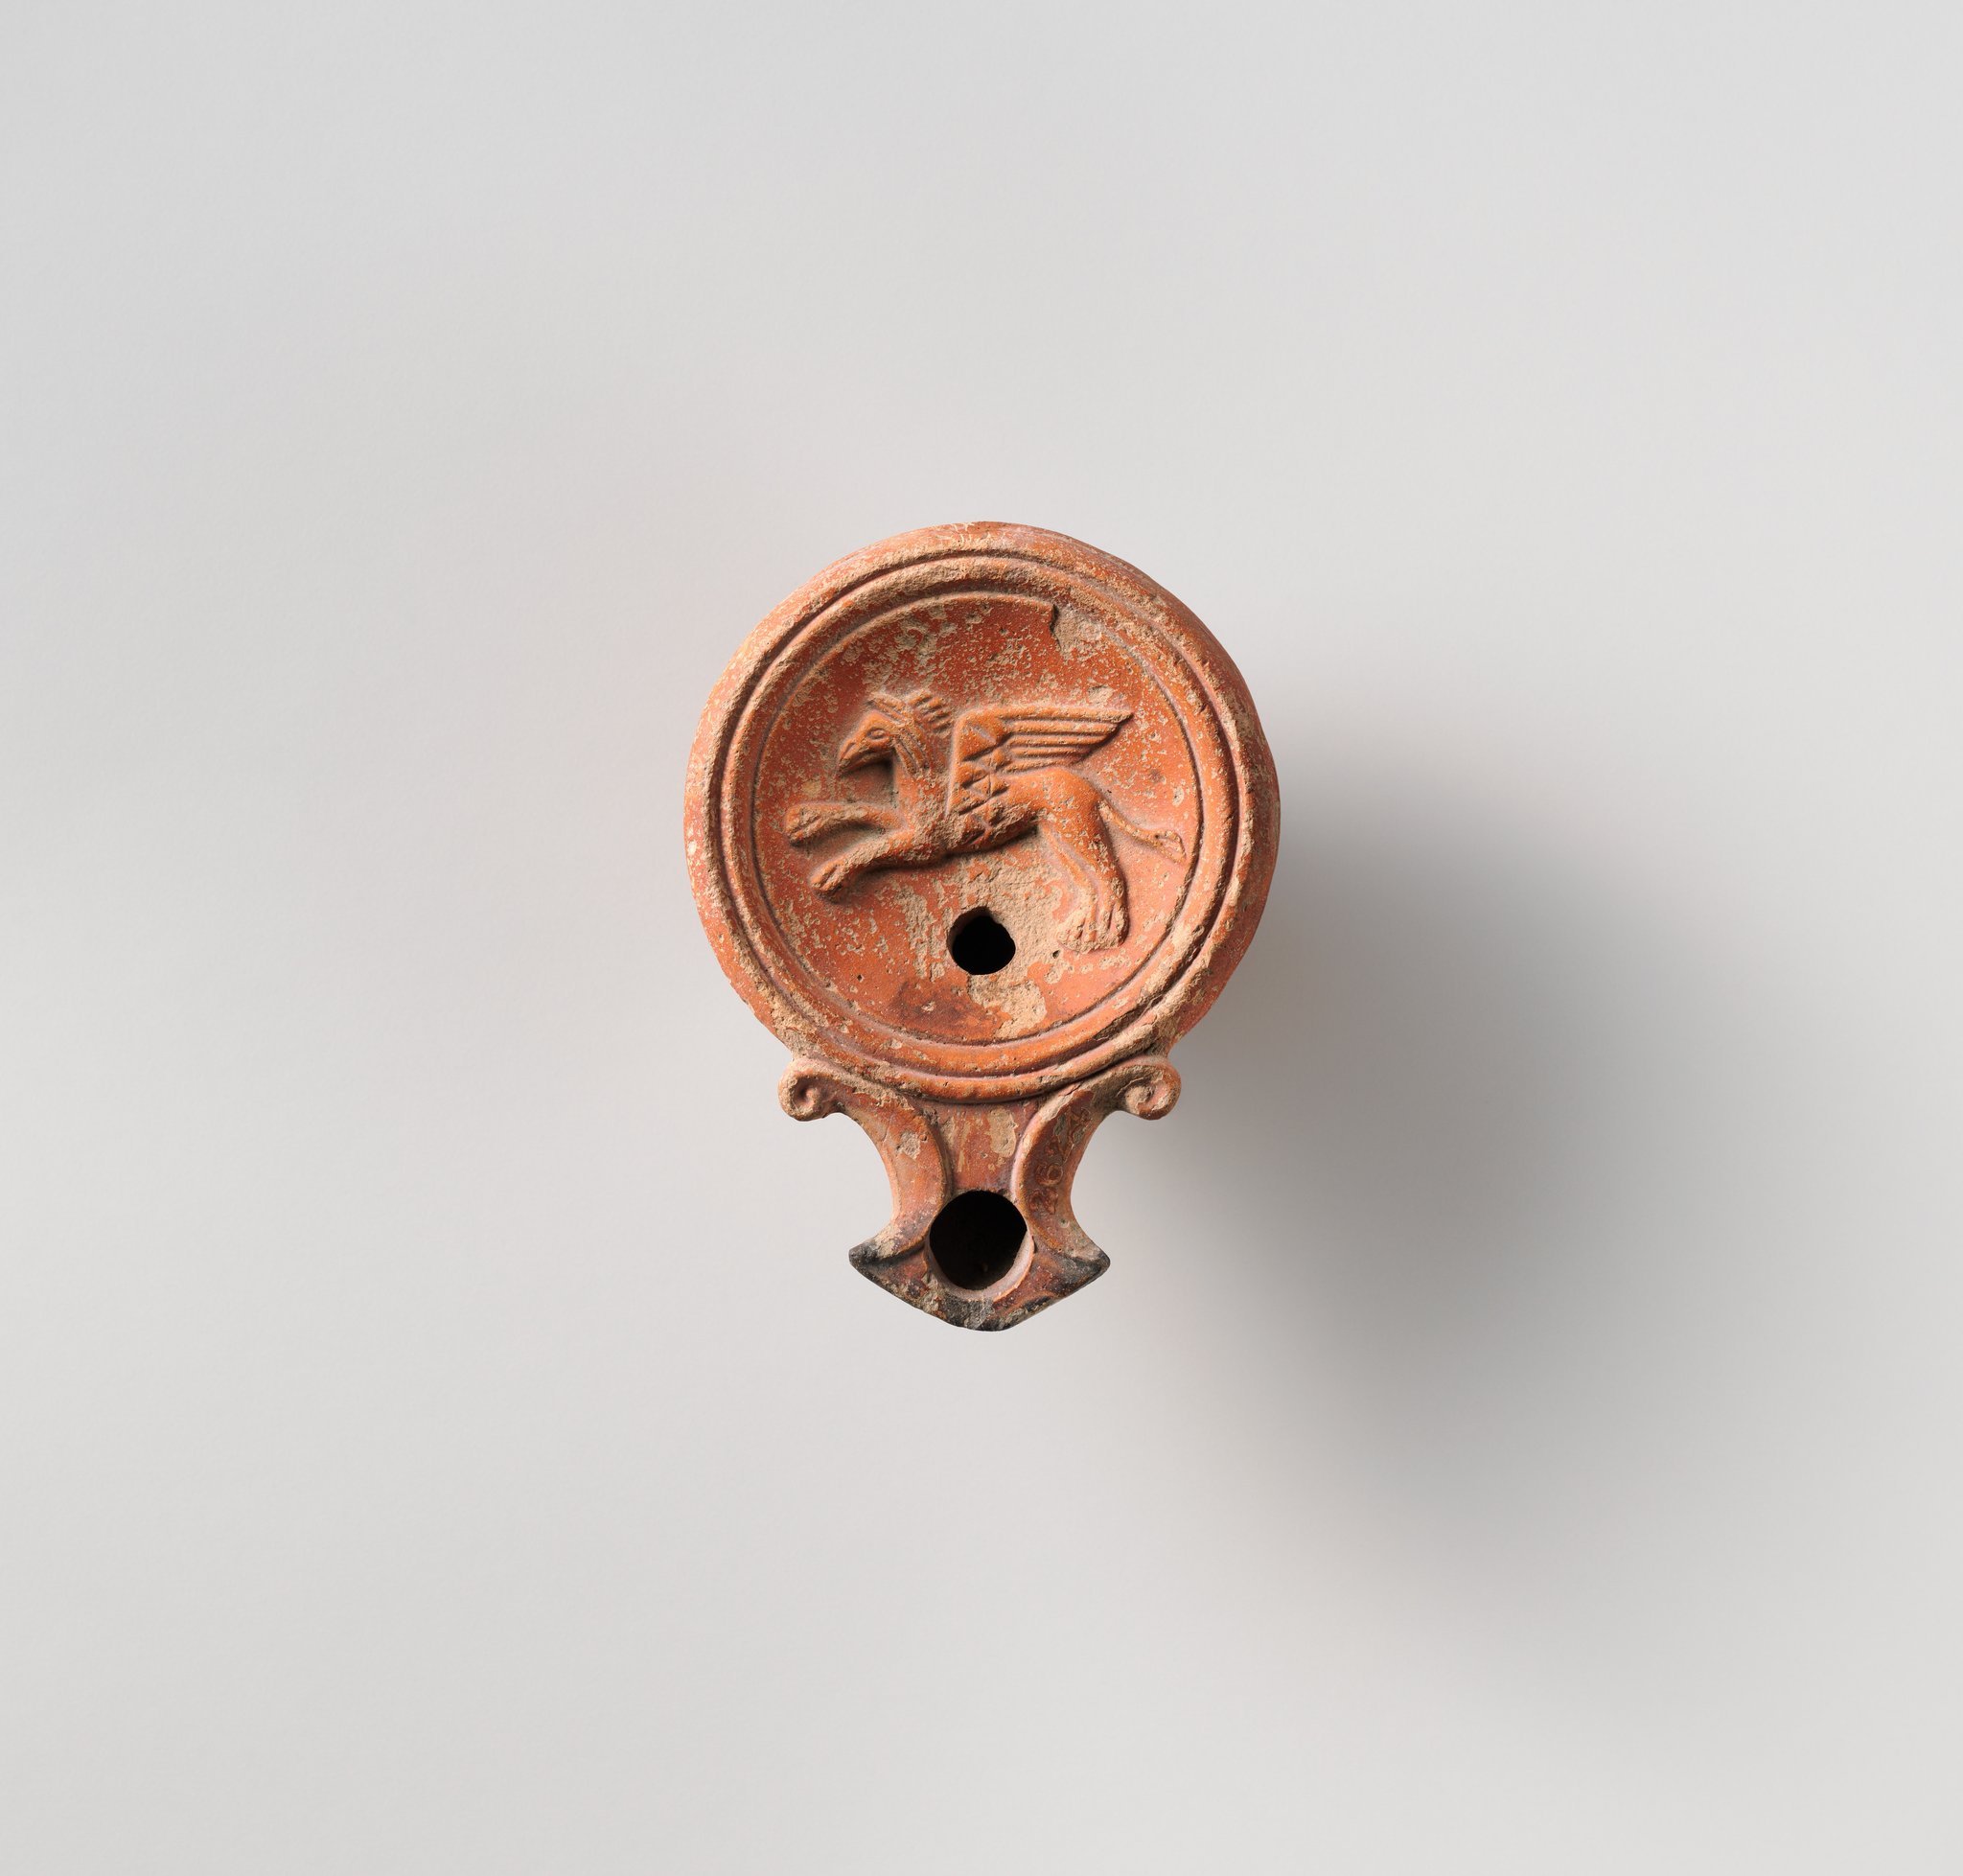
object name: lamp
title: Terracotta oil lamp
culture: roman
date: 20 BCE-25 CE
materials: terracotta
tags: griffins